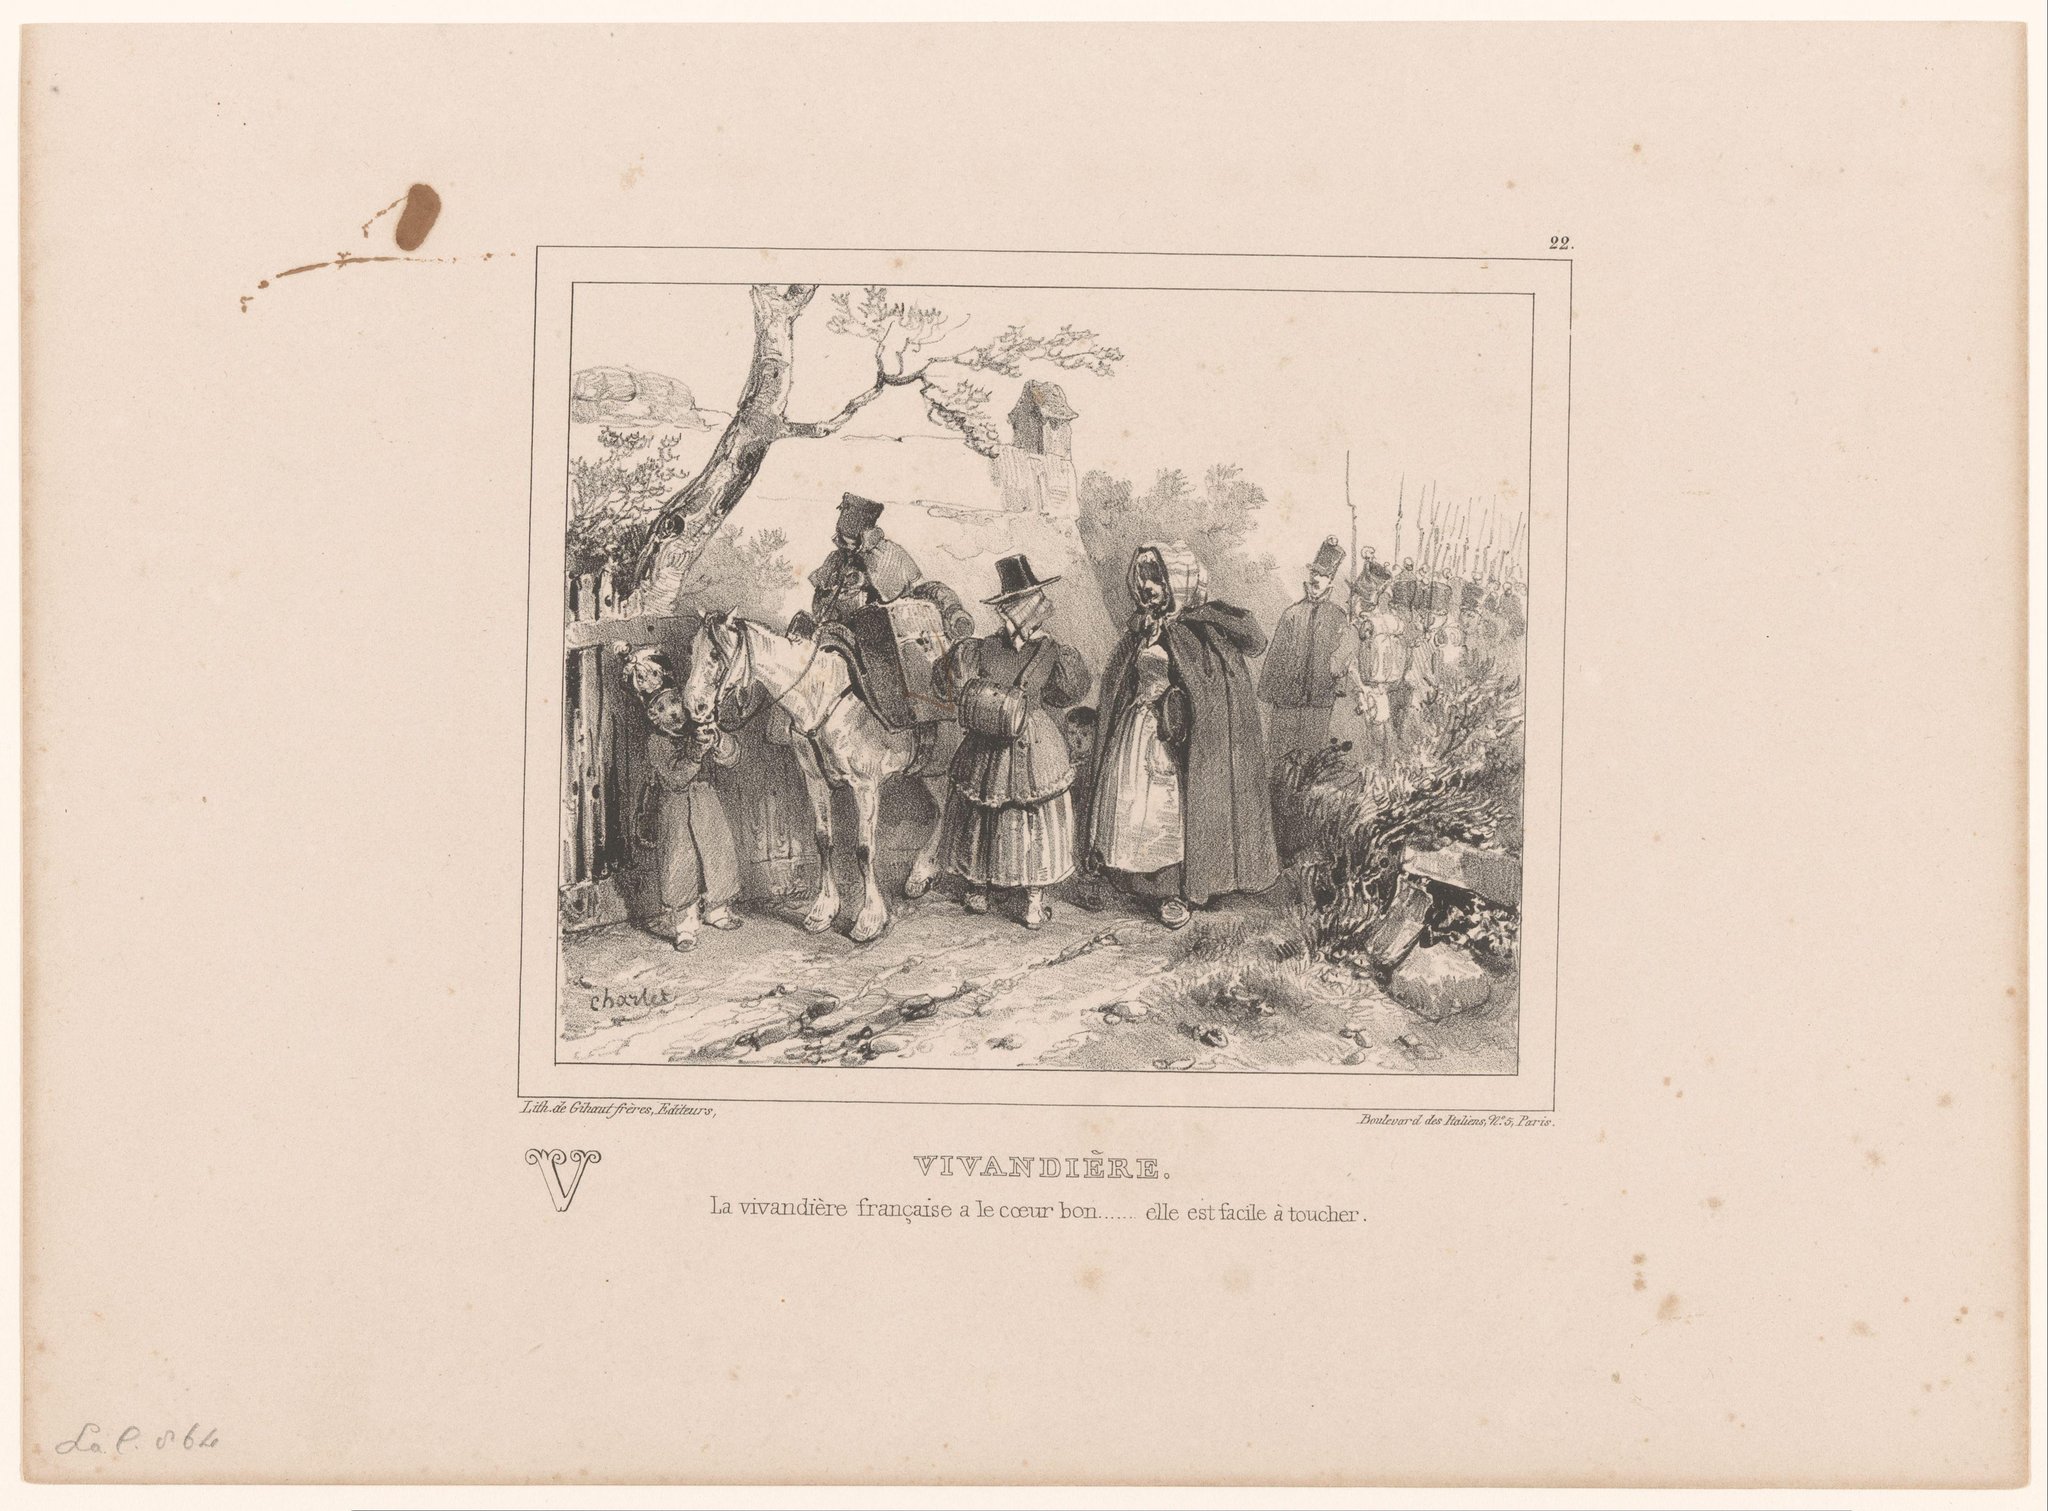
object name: print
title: Alfabet met een moraal voor kinderen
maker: nicolas toussaint charlet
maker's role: draughtsman, painter, print maker, printer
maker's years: 1792-1845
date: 1835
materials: paper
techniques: lithograph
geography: paris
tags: female sutler, canteen-woman (+ infantry)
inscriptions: collector's mark: Lugt 2228a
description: Een marketentster is in gesprek met een vrouw met kind. Het paard, waar een ander kind op zit, draagt proviand voor het leger. Op de achtergrond zijn infanteristen te zien.